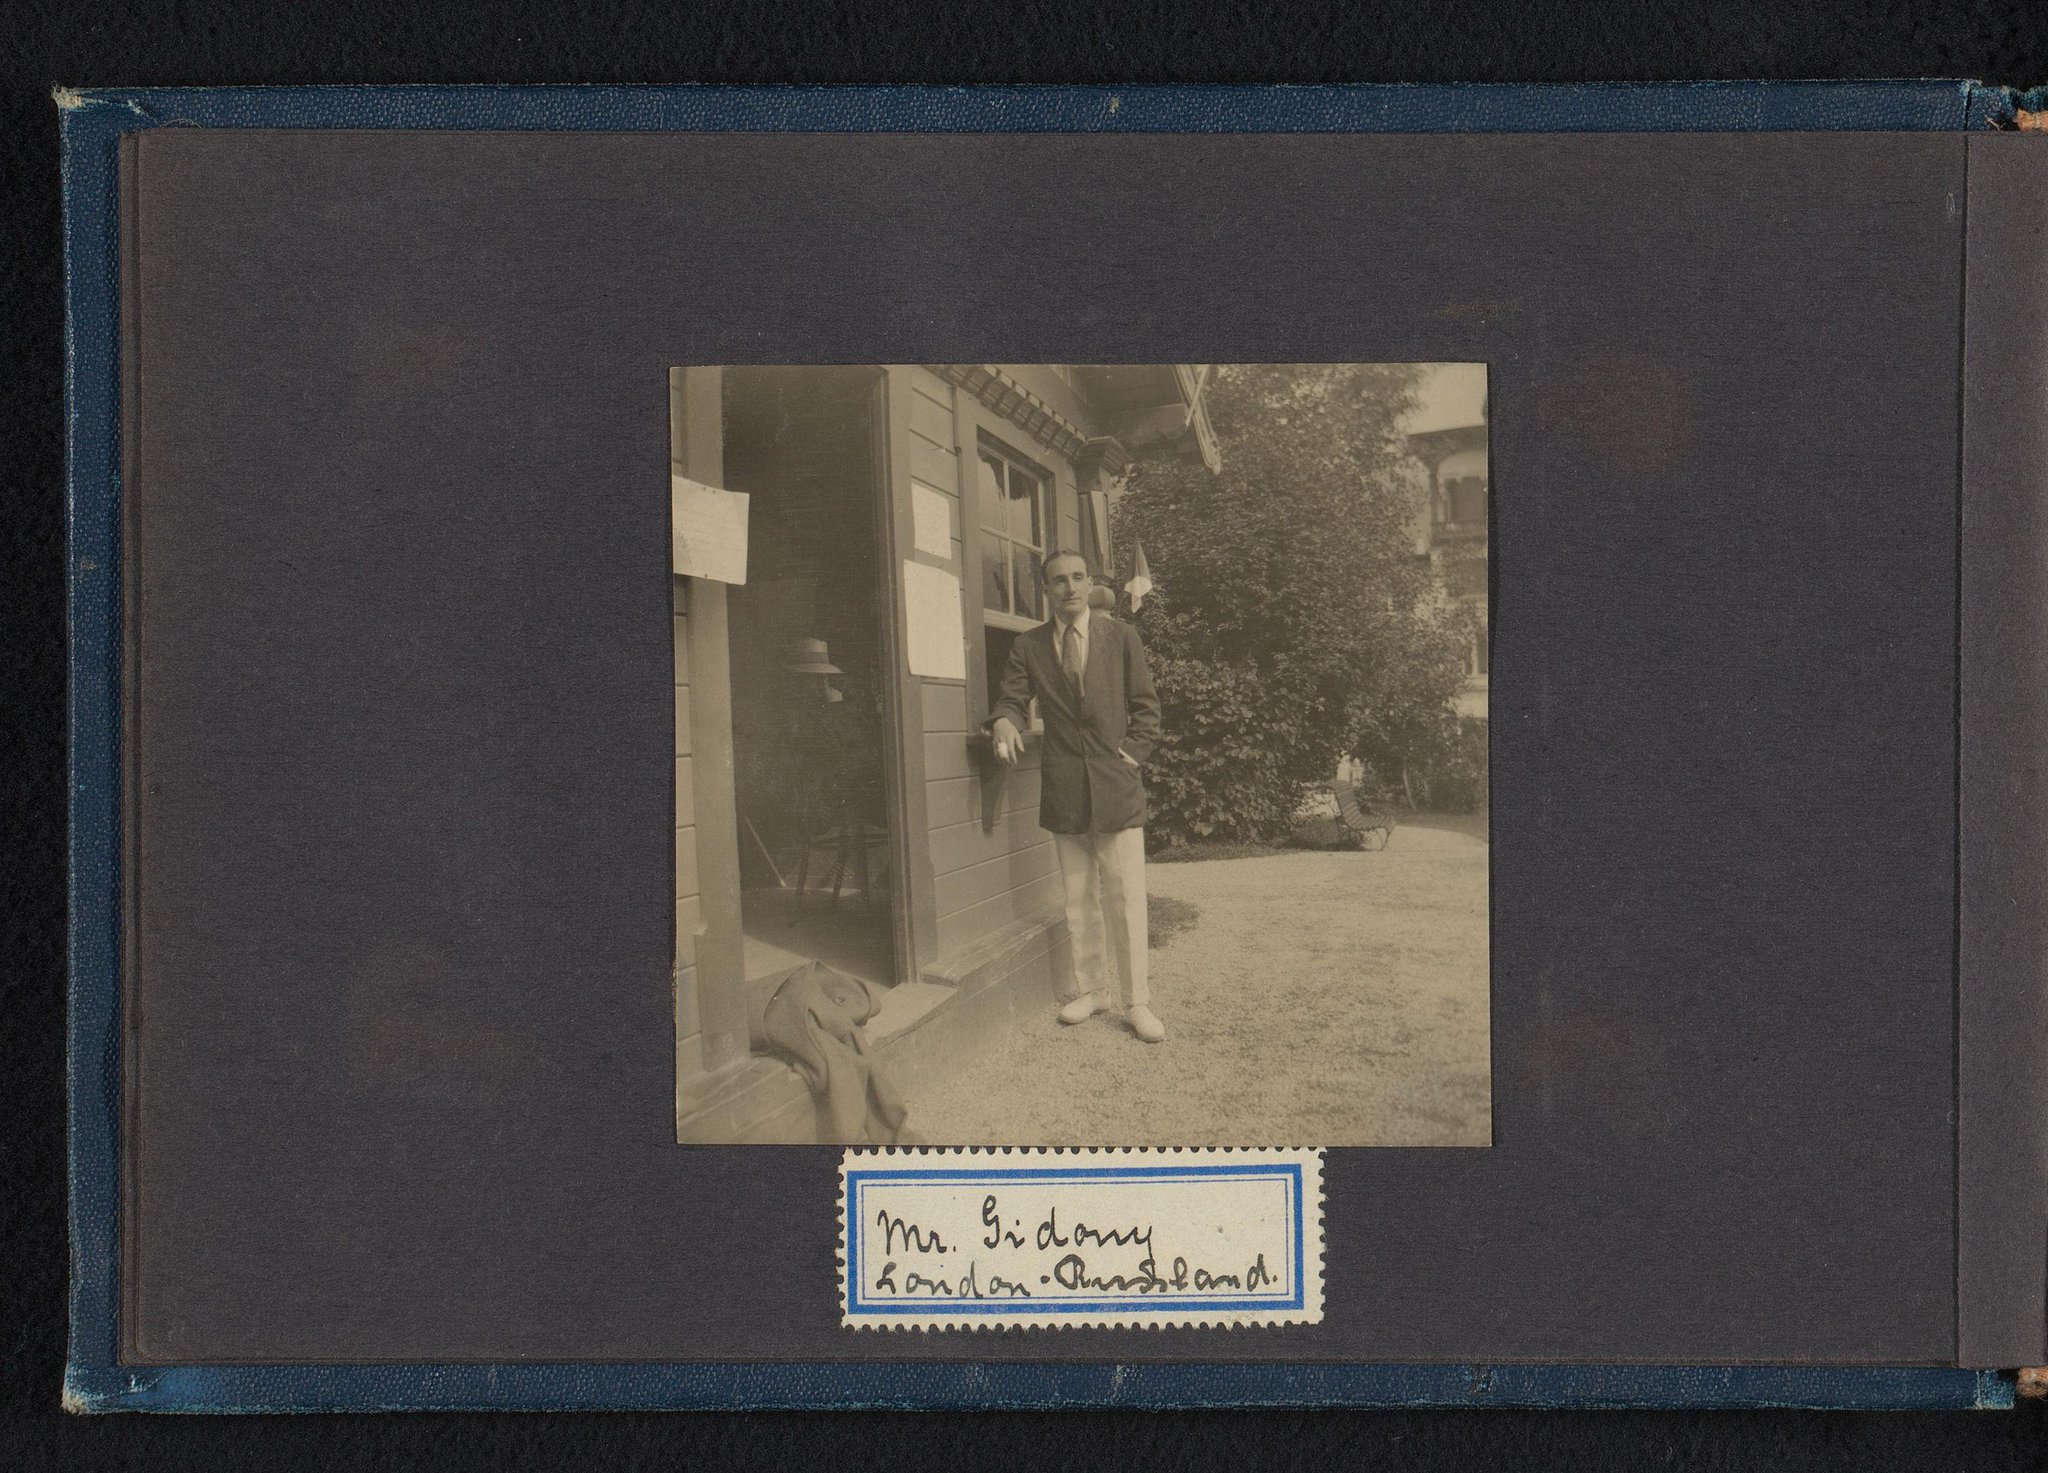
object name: photograph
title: Mr. Gidony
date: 1913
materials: paper, photographic support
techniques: gelatin silver print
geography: switzerland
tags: else wachenheimer-moos, willy moos, tennis, lawn-tennis, historical persons, switzerland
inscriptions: inscription: ‘Mr. Gidony / London . Russland.’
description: Albumblad met een foto van Mr. Gidony, bij het tennishuisje tijdens een tennistoernooi in 1913 in Waldhaus, Zwitserland. Onderdeel van het fotoalbum van Else Wachenheimer-Moos en haar broers Arthur en Willy Moos en anderen in de periode 1913-1918.